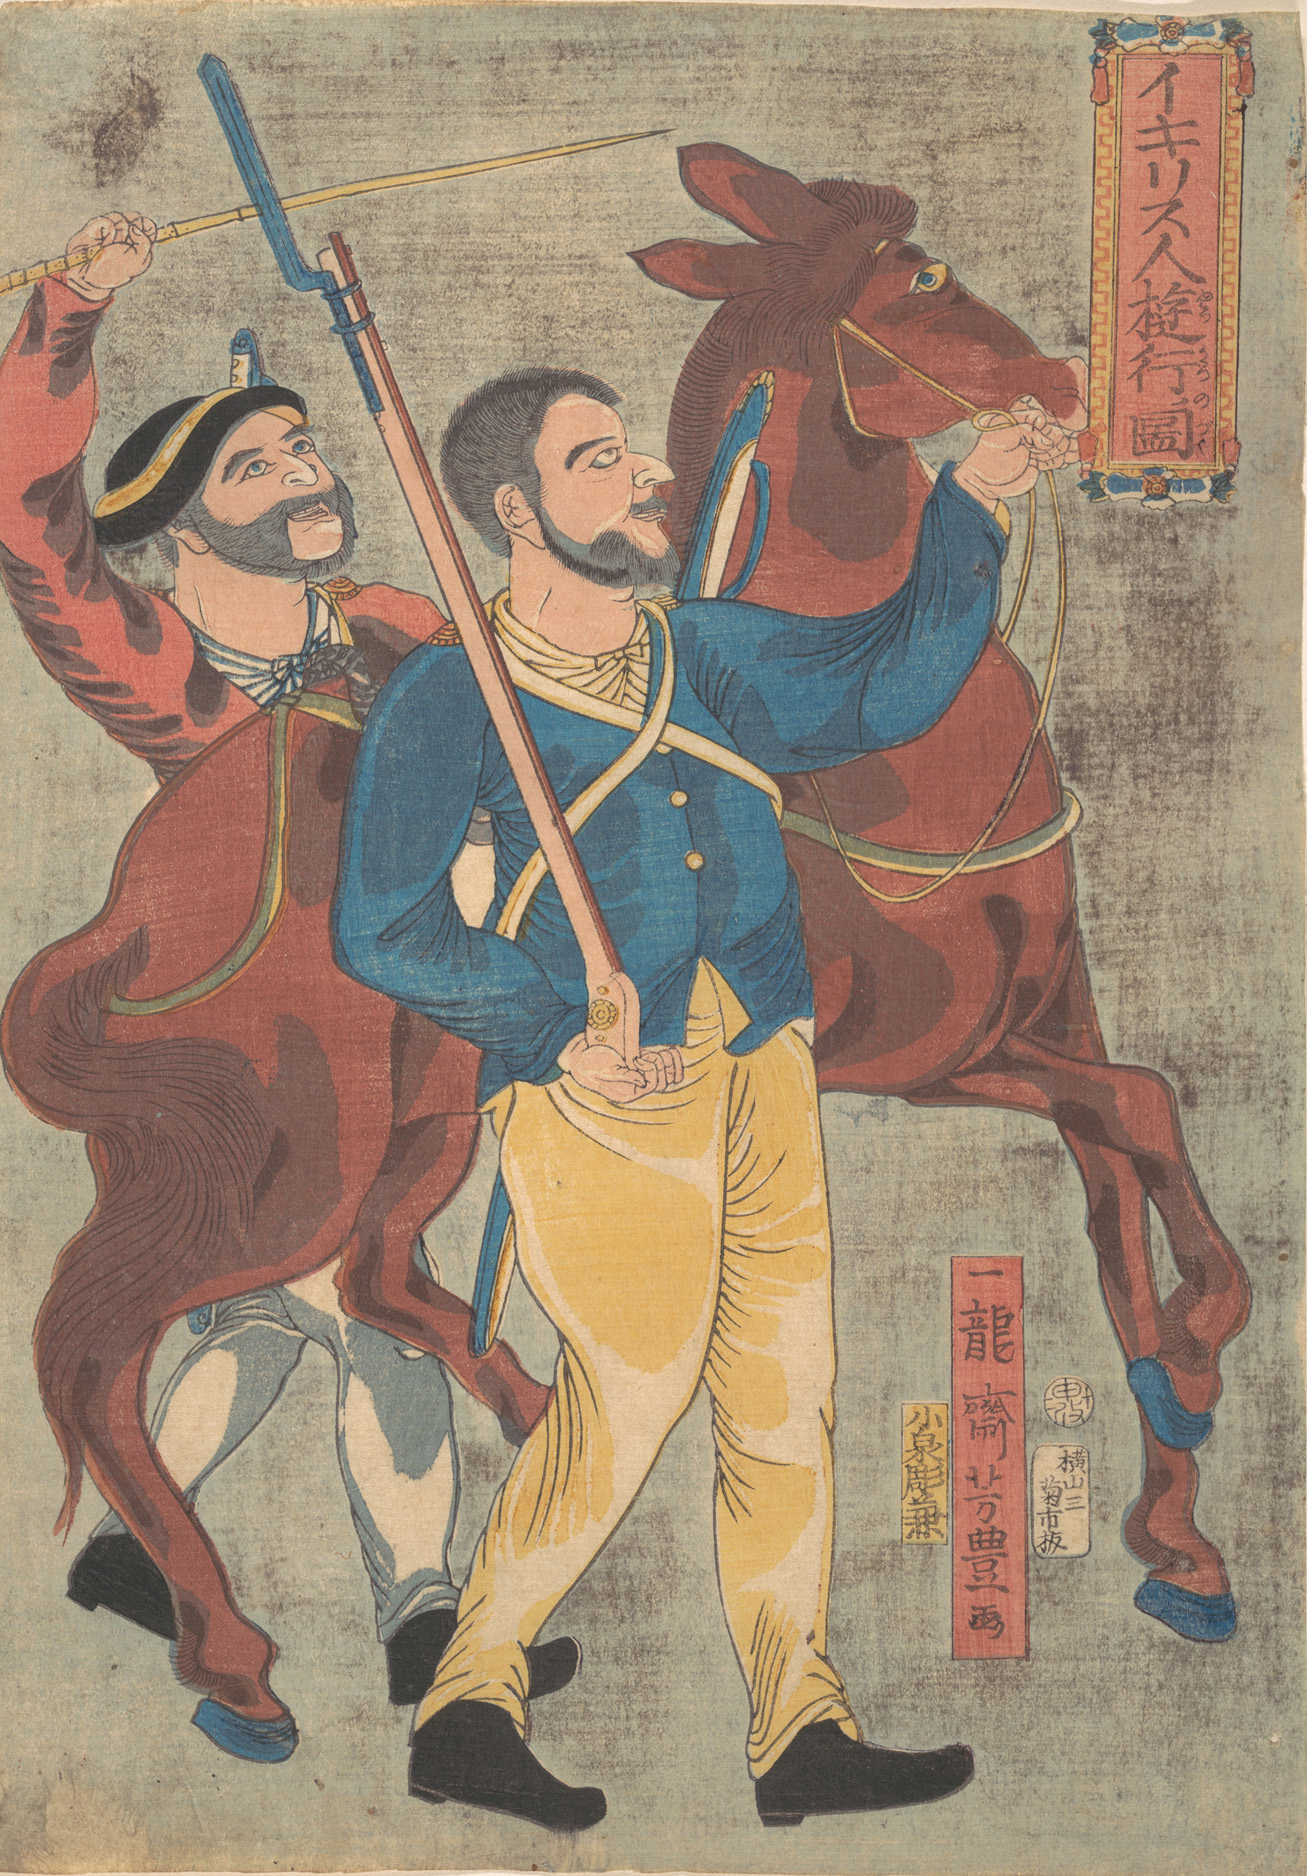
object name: print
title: Englishman Walking for Pleasure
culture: japanese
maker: ichiryūsai yoshitoyo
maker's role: artist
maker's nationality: japanese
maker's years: 1830-1866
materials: ink, paper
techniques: woodblock print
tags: men,horses